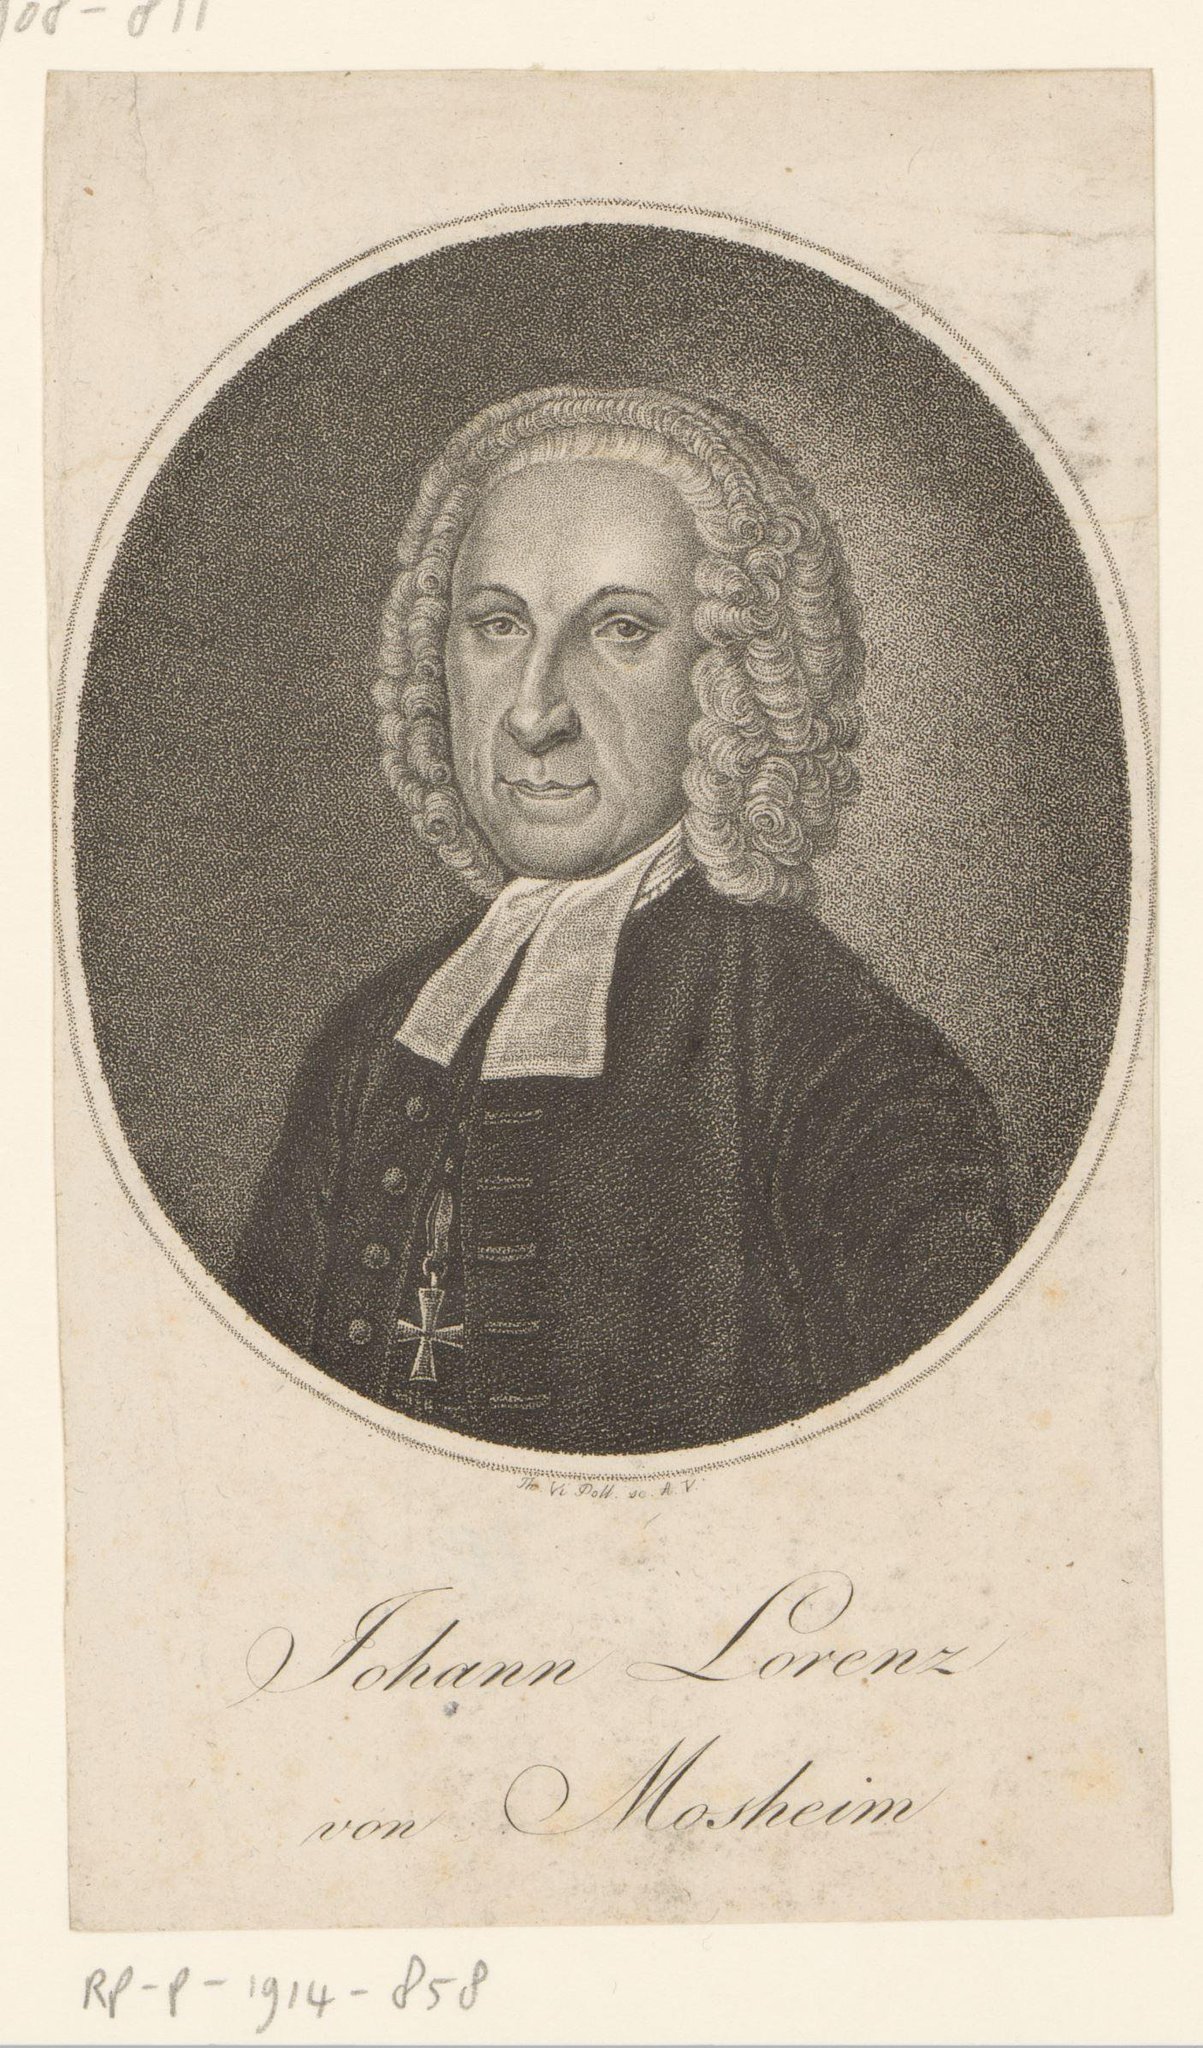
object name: print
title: Portret van Johann Lorenz von Mosheim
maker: theodor vincenz poll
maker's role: print maker, publisher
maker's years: 1770-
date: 1780-1880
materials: paper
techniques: engraving, etching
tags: historical persons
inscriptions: collector's mark: Lugt 2228